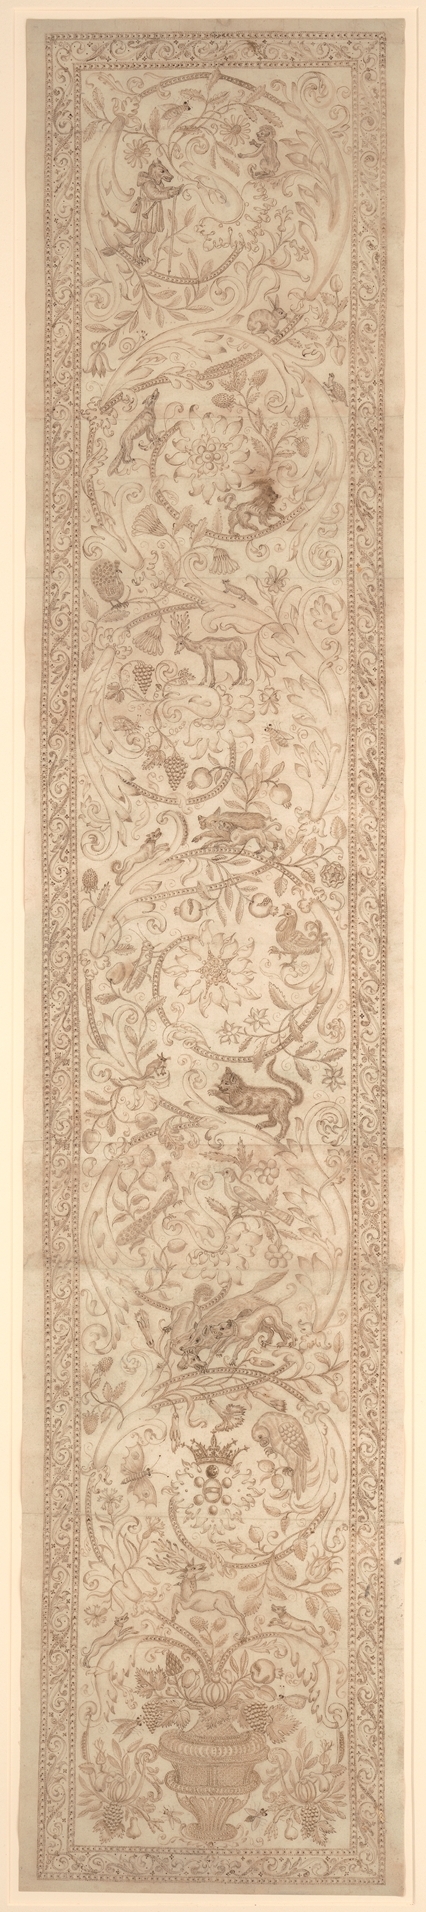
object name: drawing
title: Cartoon for the embroidery of an orphrey bearing Medici arms combined with Arms of the House of Austria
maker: anonymous, italian, 17th century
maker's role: artist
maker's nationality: italian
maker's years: 1600-1700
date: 1608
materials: ink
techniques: pen